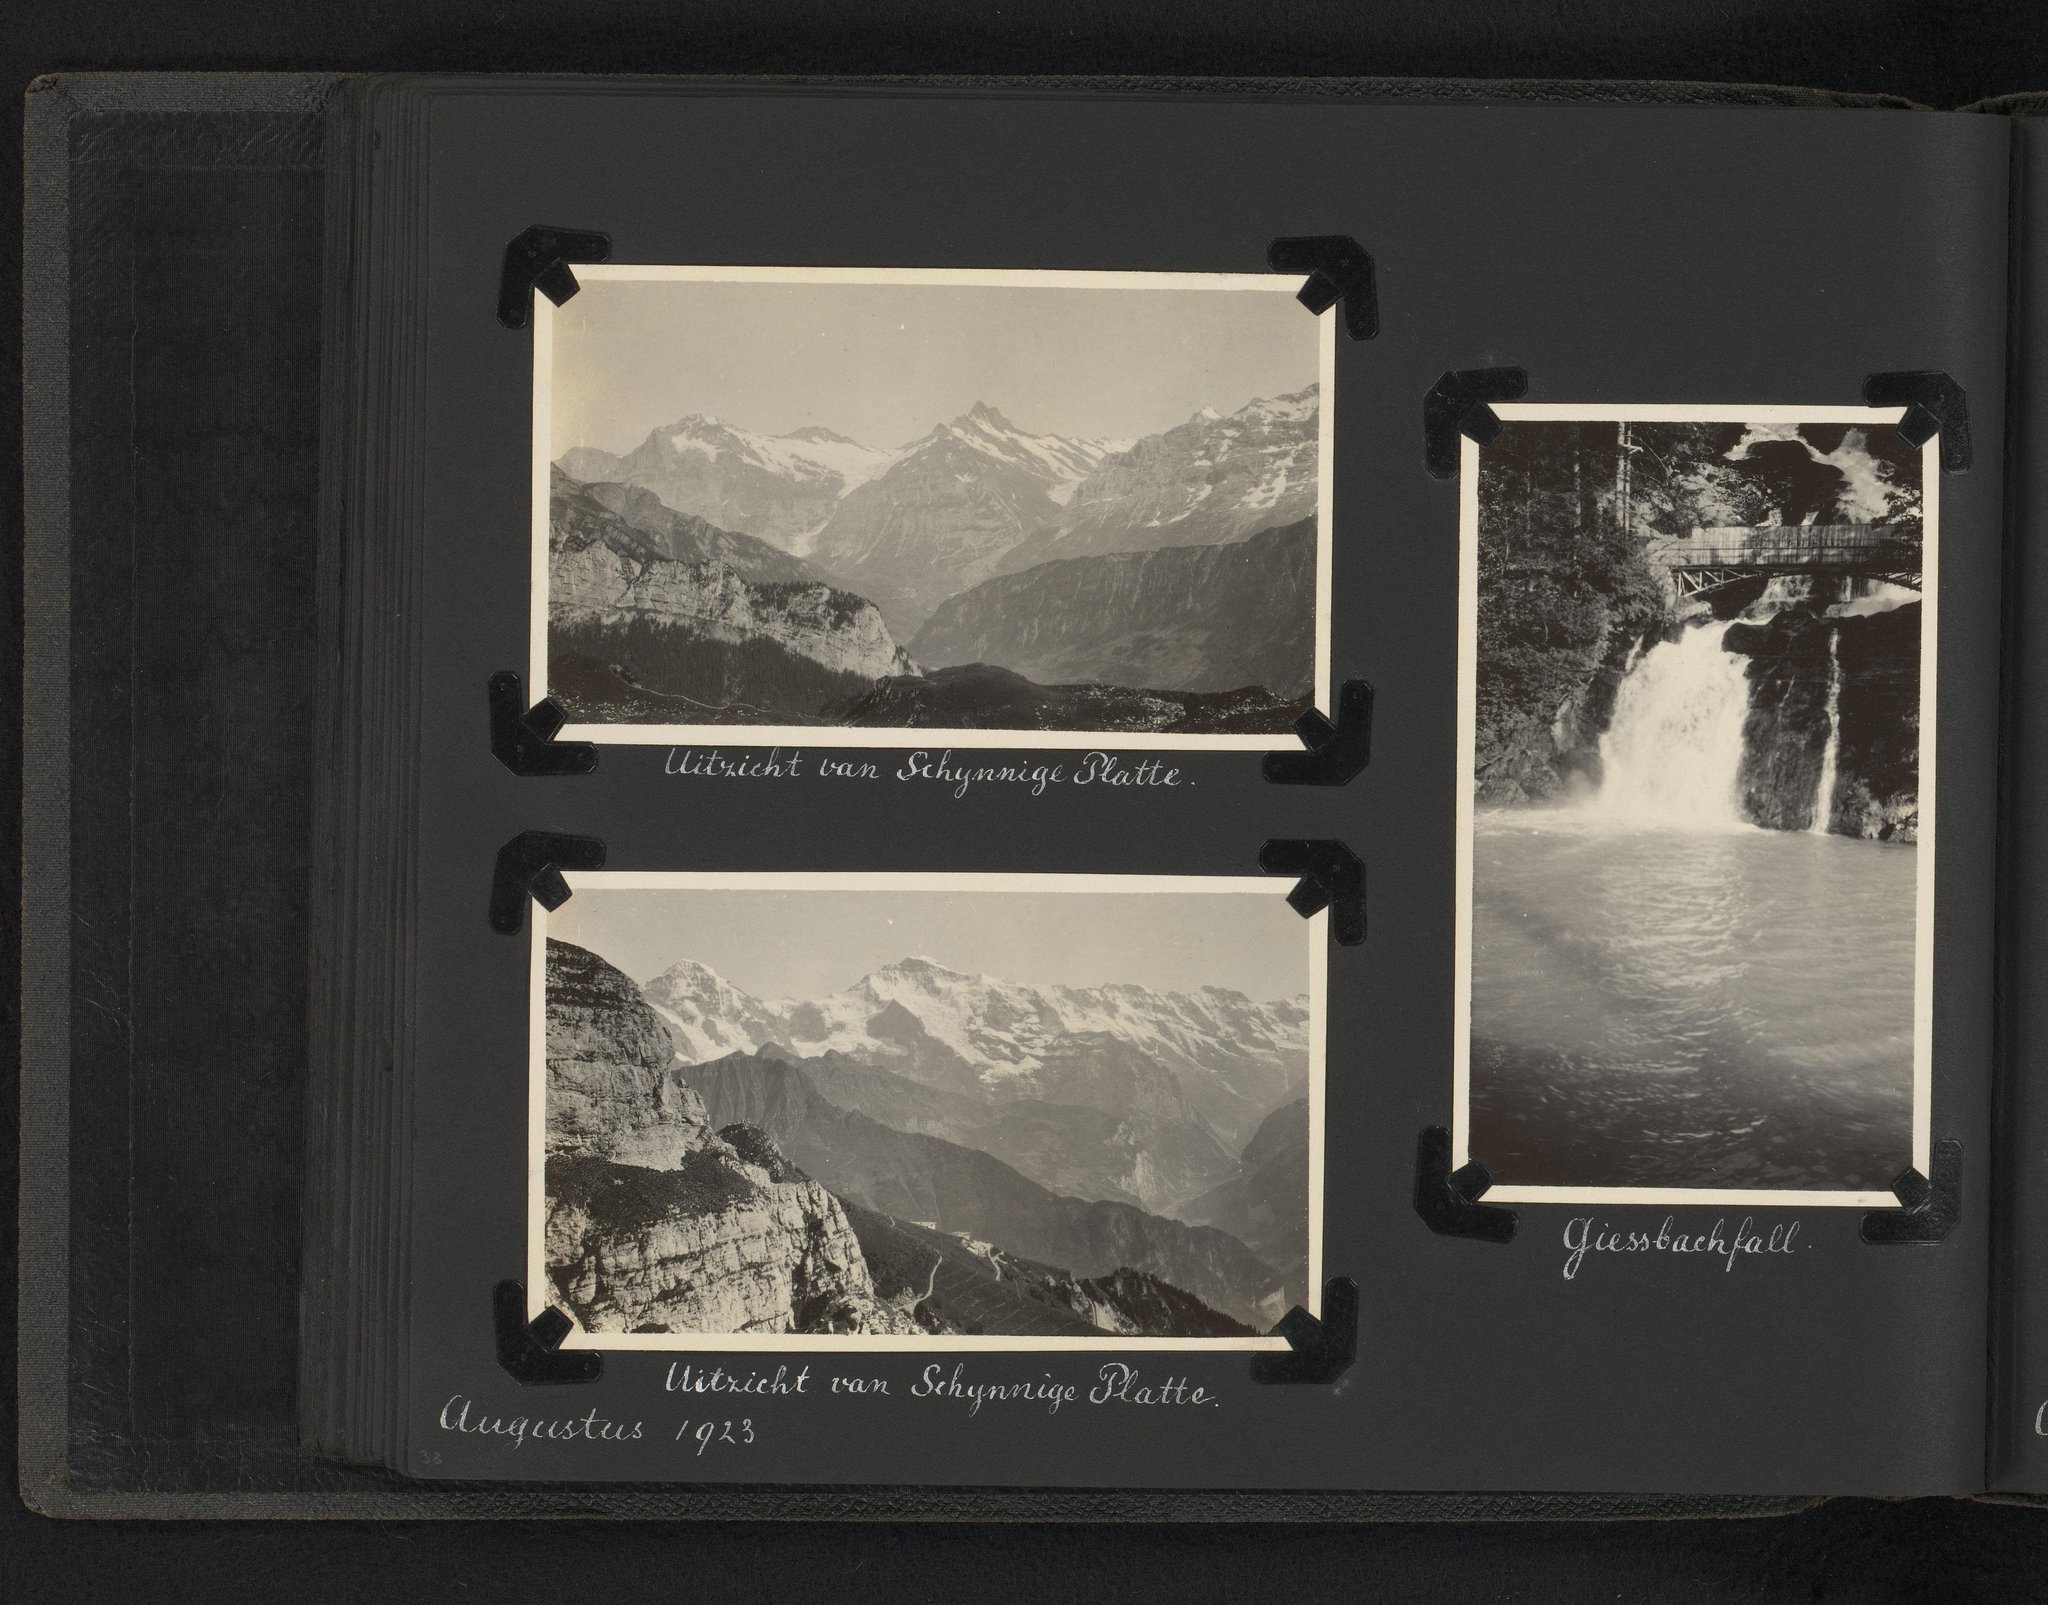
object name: album leaf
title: Augustus 1923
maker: hendrik herman van den berg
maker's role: amateurfotograaf, jurist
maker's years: 1875-1944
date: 1908-1923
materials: paper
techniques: gelatin silver print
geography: bern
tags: waterfall, mountains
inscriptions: inscription: ‘UItzicht van Schynnige Platte’, inscription: ‘Giessbachfall’, inscription: ‘UItzicht van Schynnige Platte’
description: Deze foto's maken deel uit van een album.